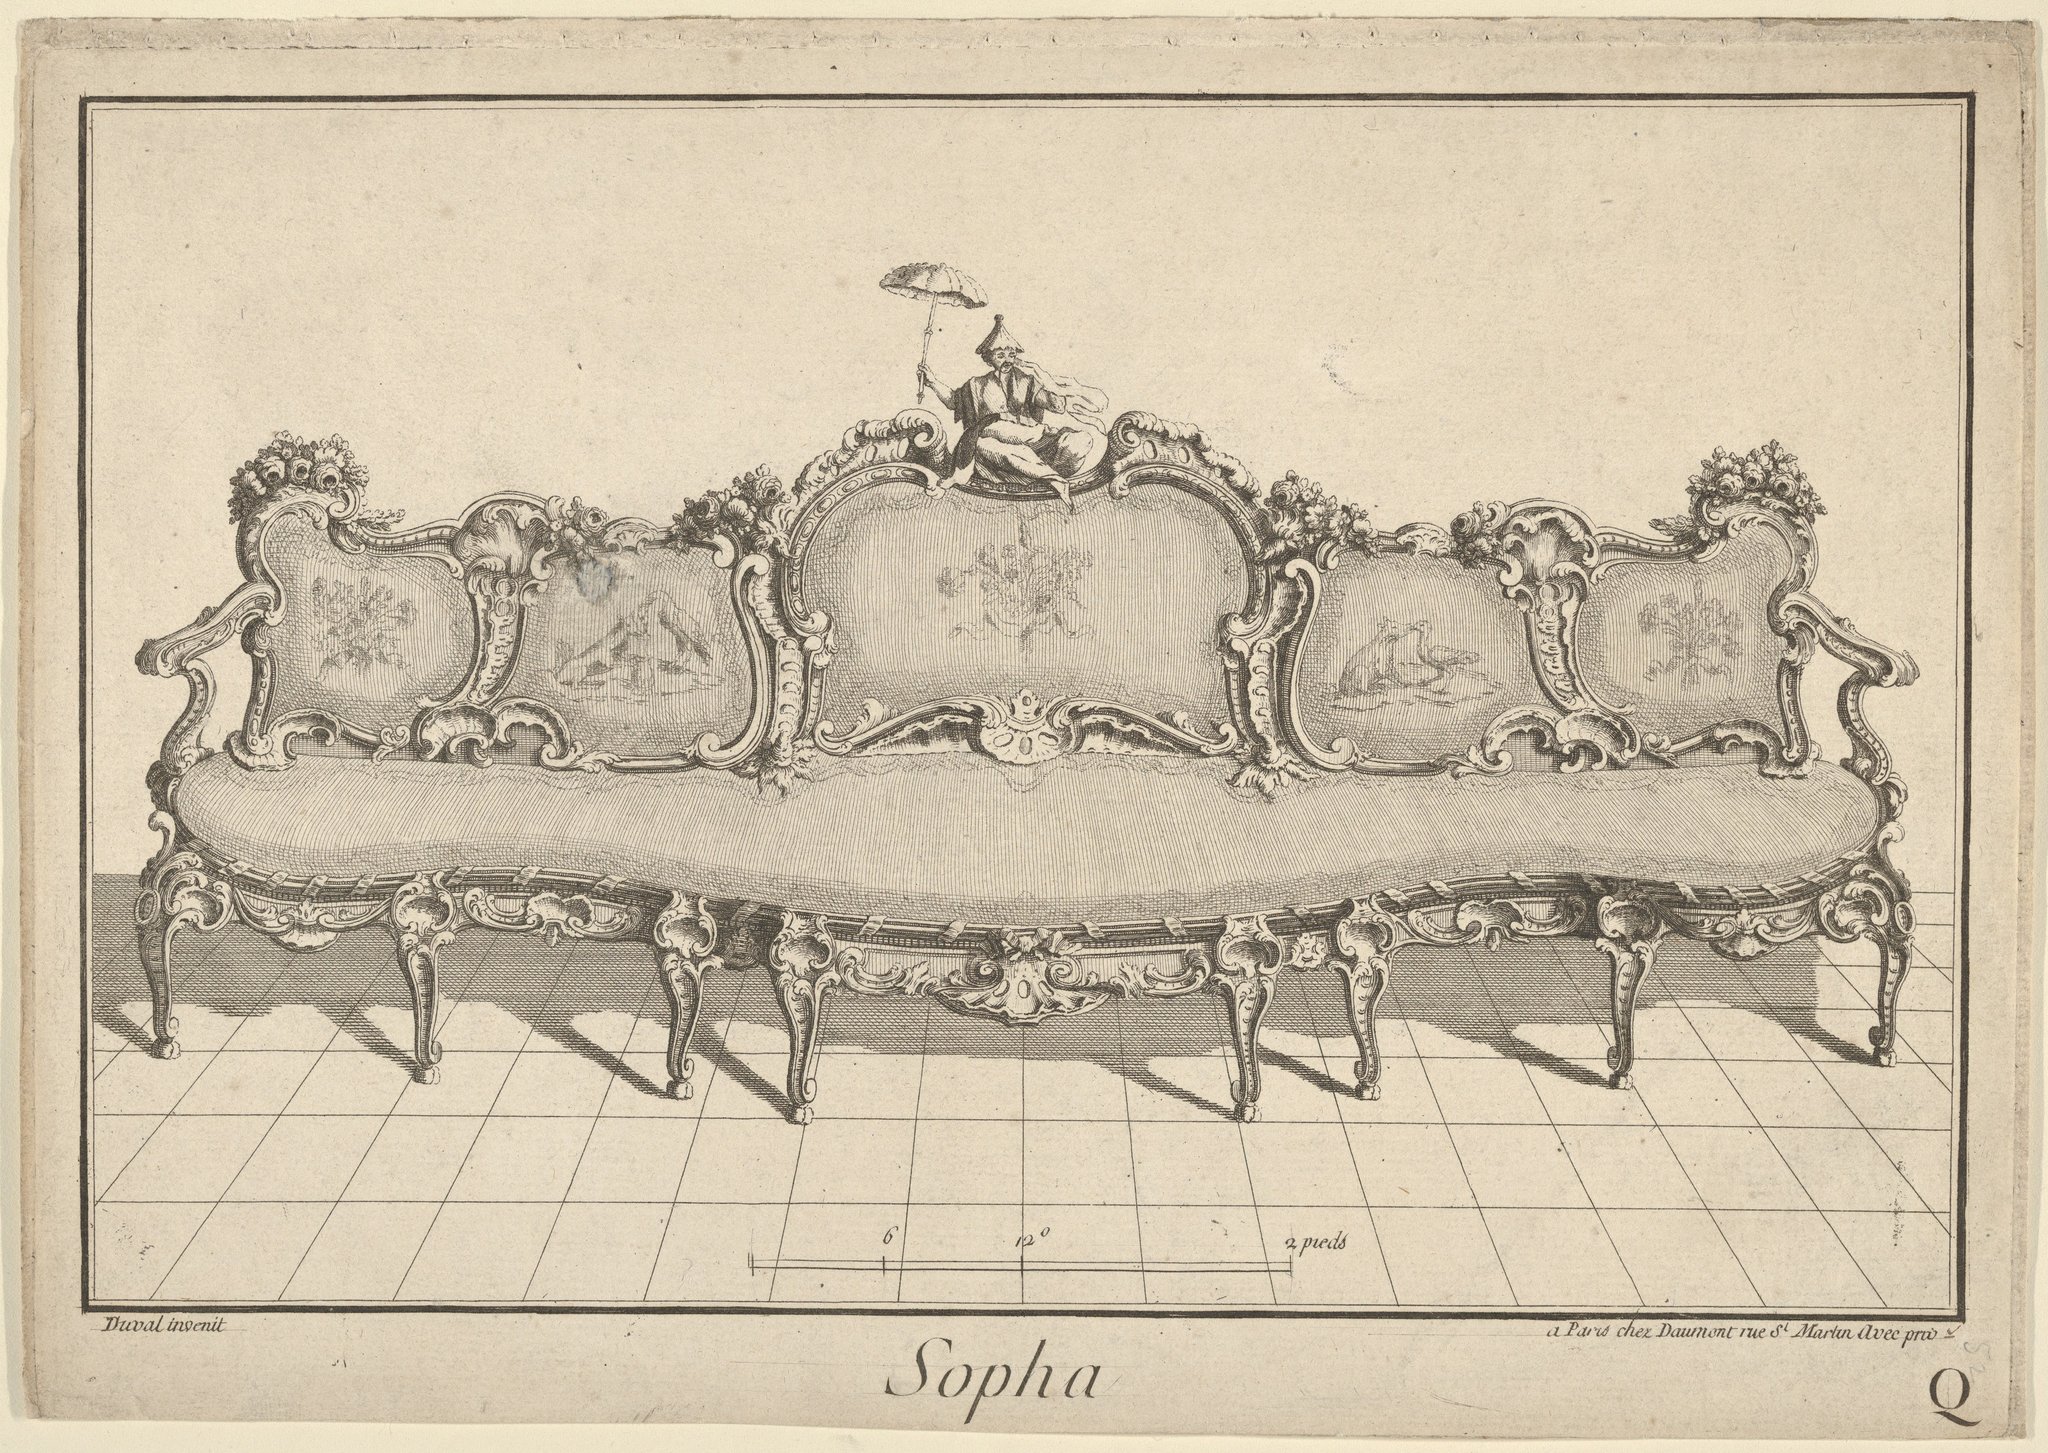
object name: print ornament architecture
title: Design for a Sofa, from: Nouvelle Iconographie Historique III, series Q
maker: duval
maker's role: artist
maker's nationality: french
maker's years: 1750-1780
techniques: engraving, etching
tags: furniture